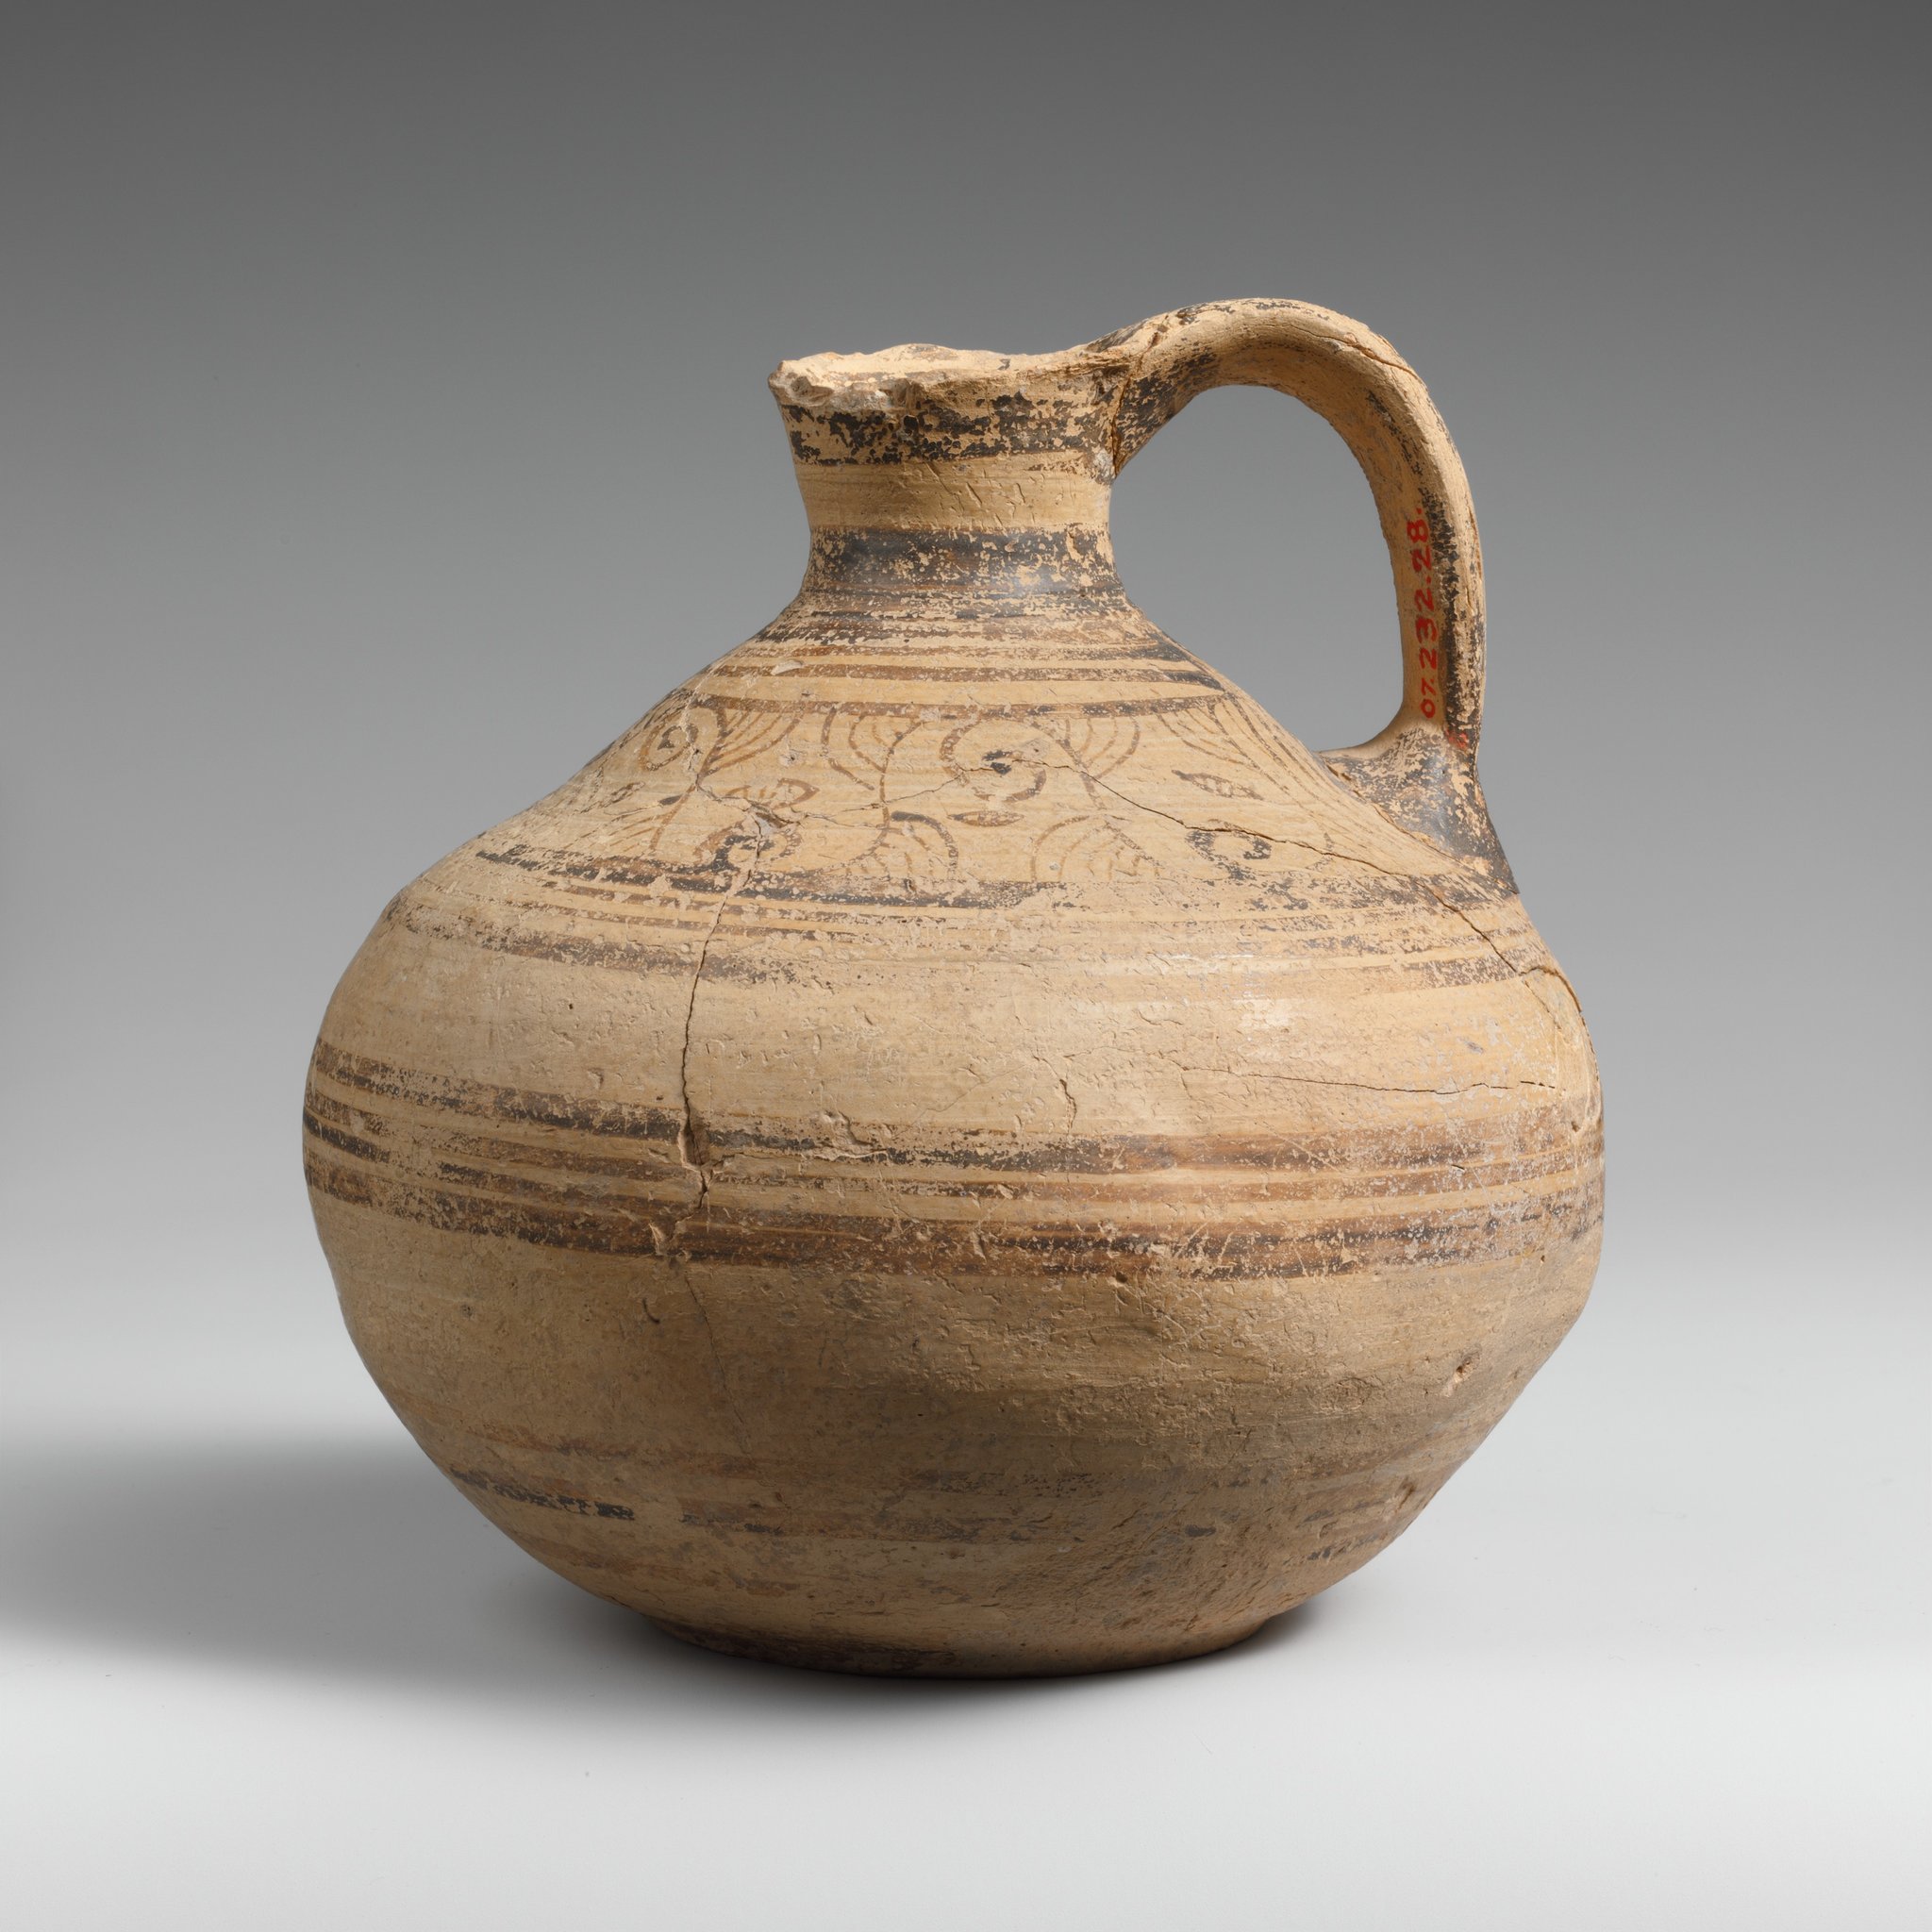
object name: jug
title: Terracotta globular jug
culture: minoan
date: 1300-1200 BCE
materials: terracotta